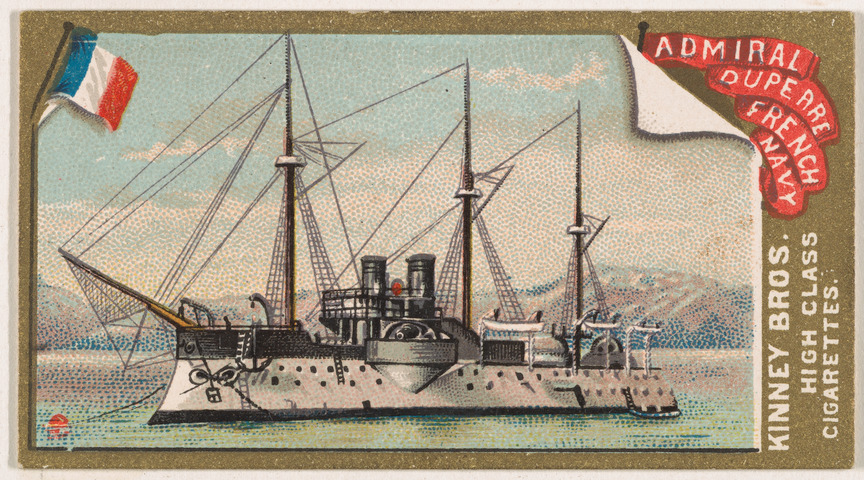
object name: print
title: Admiral Dupeare, French Navy, from the Naval Vessels of the World series (N226) issued by Kinney Bros.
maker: kinney brothers tobacco company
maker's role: publisher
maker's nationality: american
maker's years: 1869-2011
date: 1889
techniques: color lithograph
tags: navy,ships